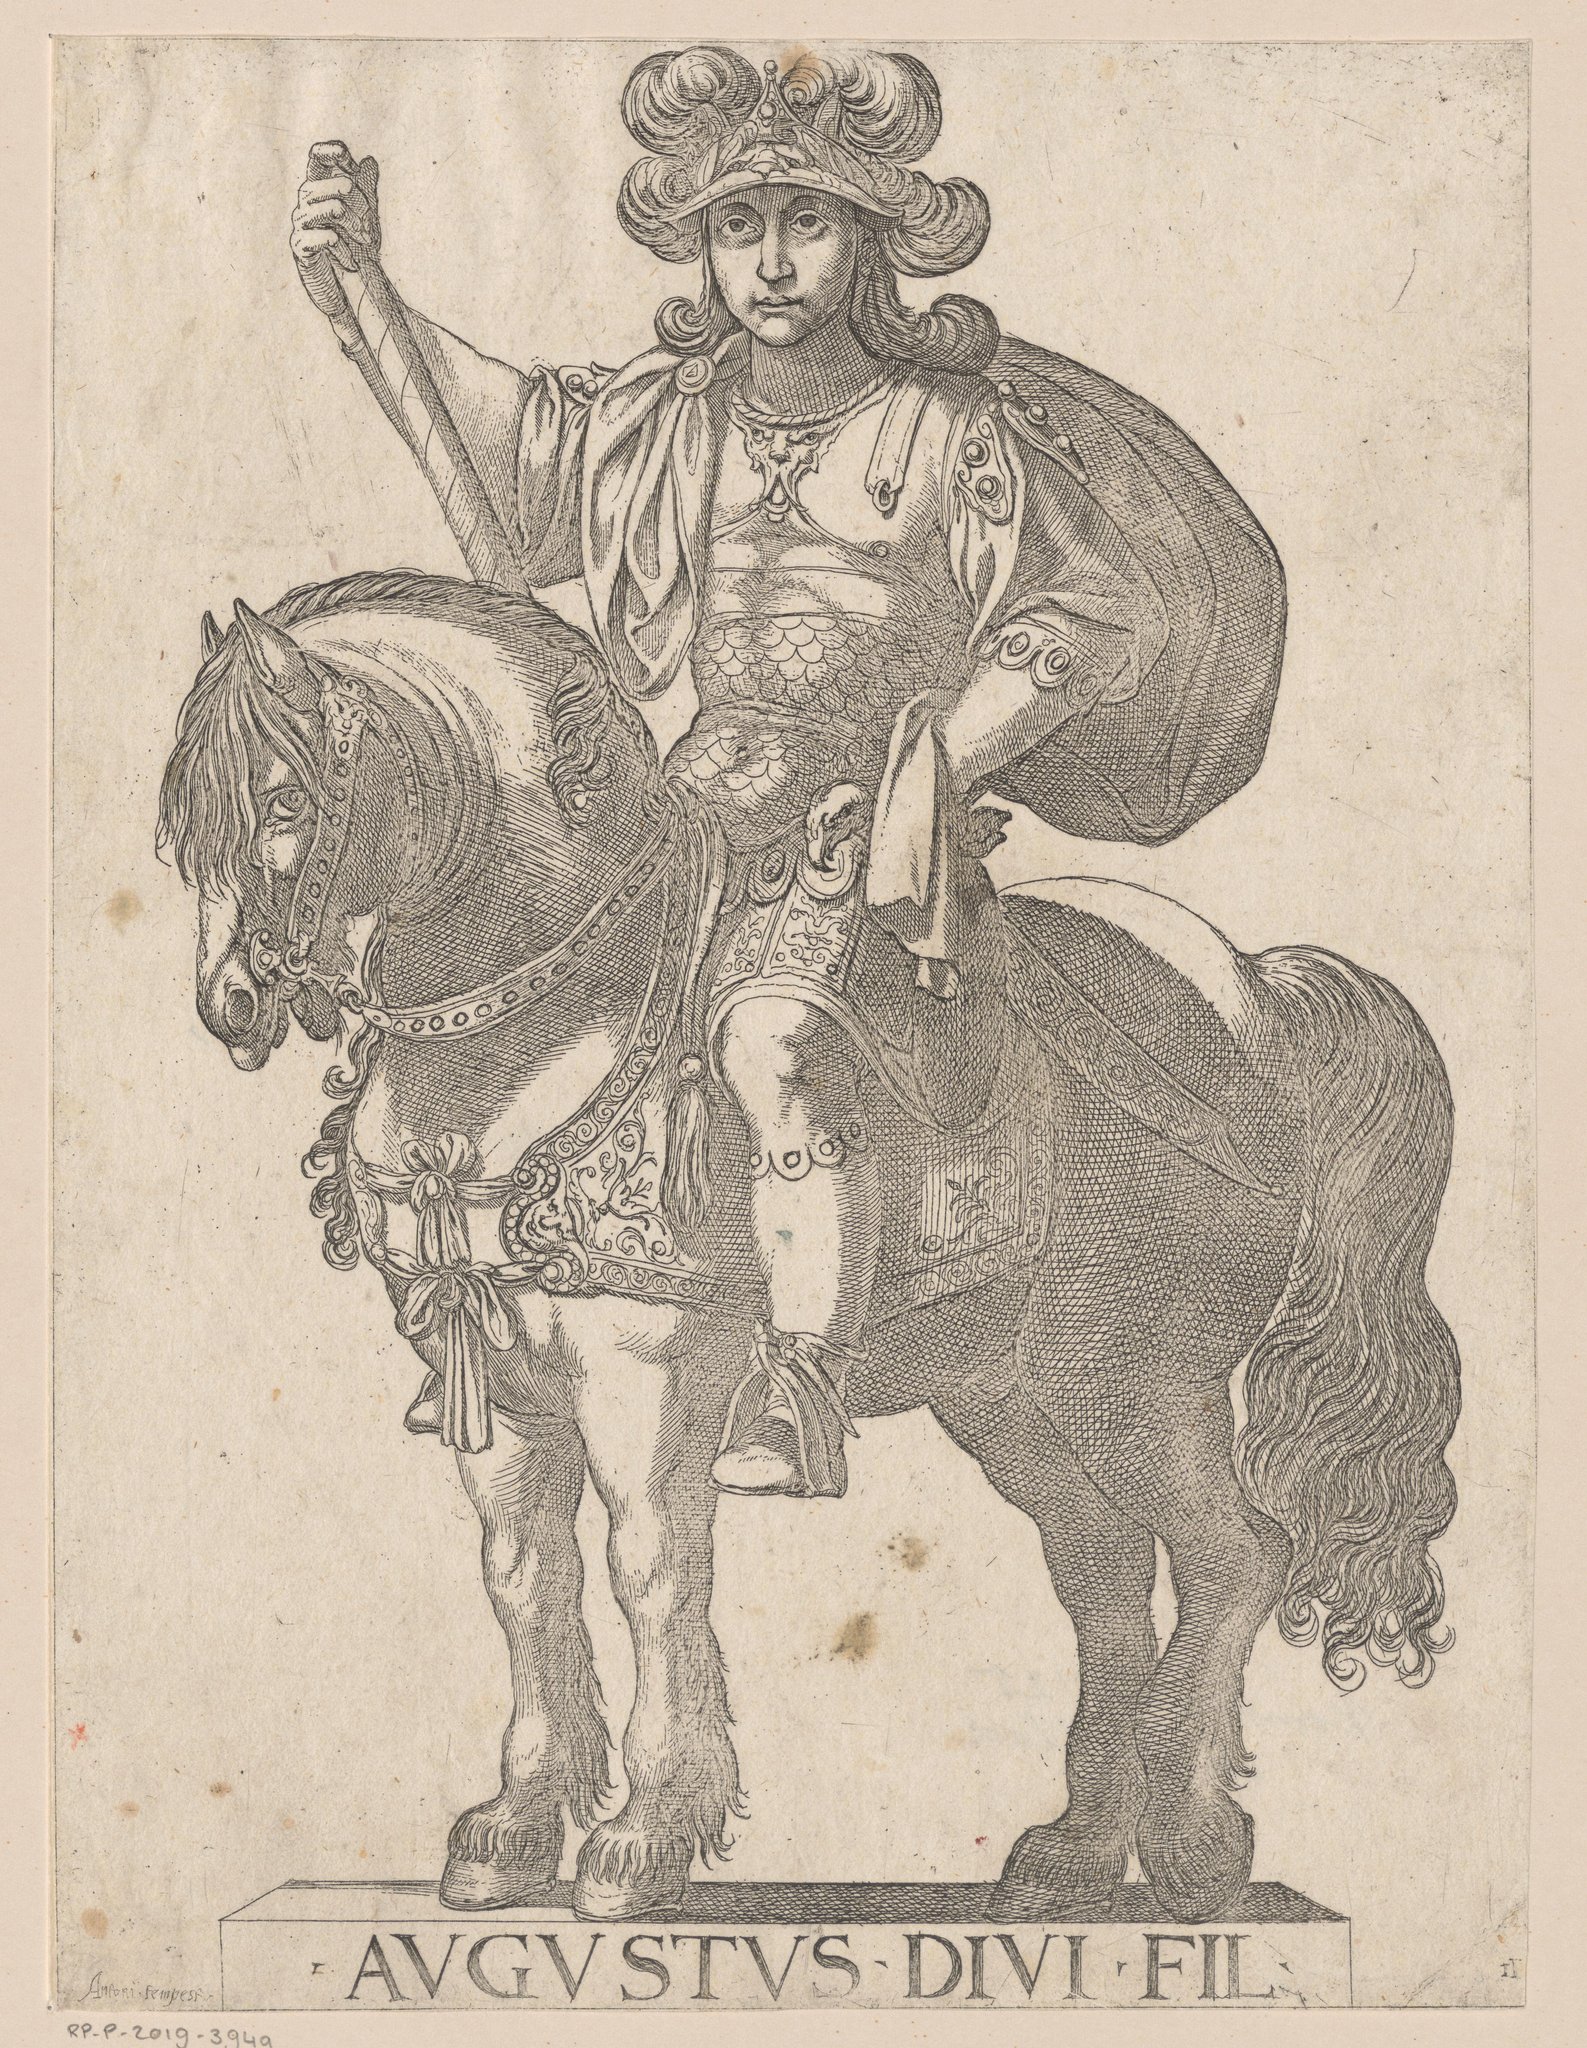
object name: print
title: Eerste twaalf Romeinse keizers te paard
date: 1596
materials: paper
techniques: etching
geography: rome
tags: portrait of augustus, historical persons, equestrian statue